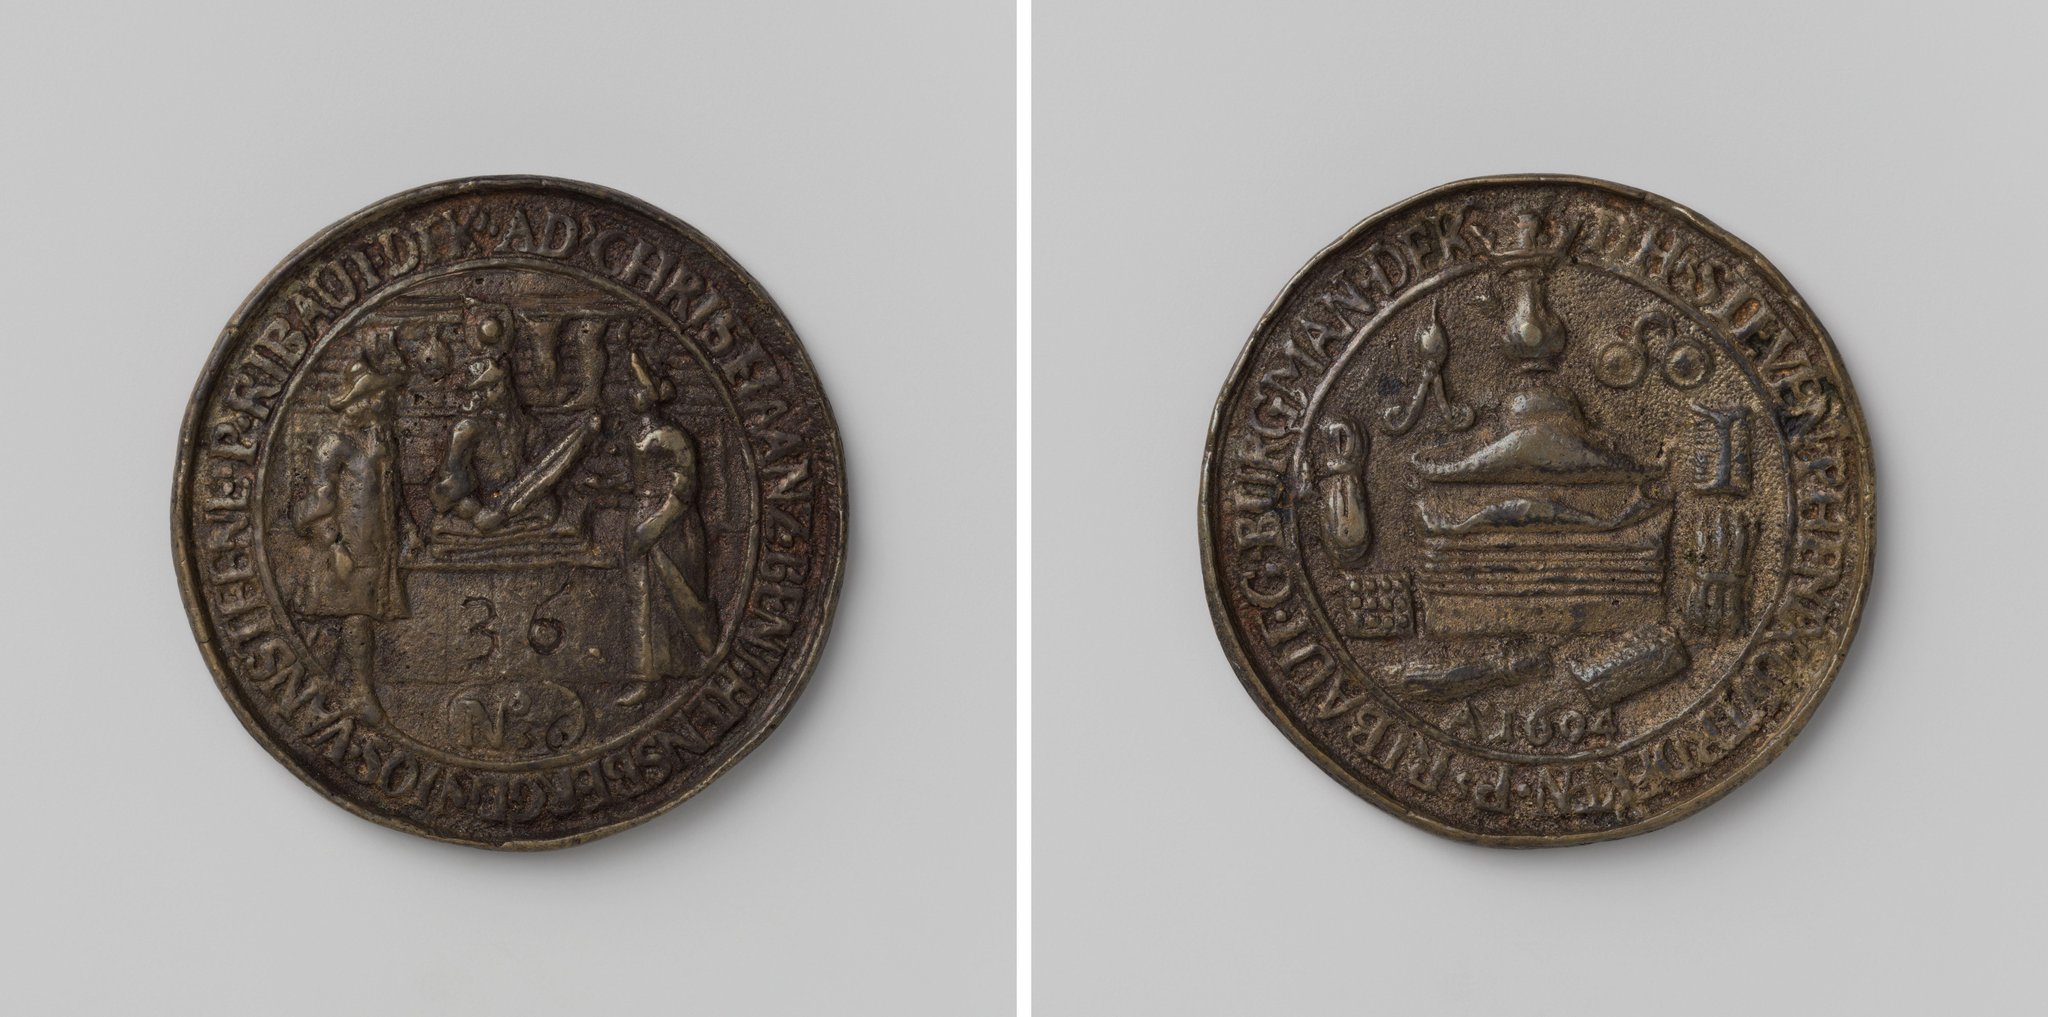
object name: medal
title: Zijdelakenkopersgilde van Vlissingen, gildepenning met no. 36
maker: Anonymous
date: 1694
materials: brass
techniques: casting, engraving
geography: flushing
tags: flushing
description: Guilds were urban organisations of people in specific occupations. The guild represented the interests of the profession. Each member had a token as proof of membership. The person’s name was engraved on one side of the token, often together with the arms of the guild or of the city in which it was based. The other side carried a motif signifying the occupation represented by the guild.